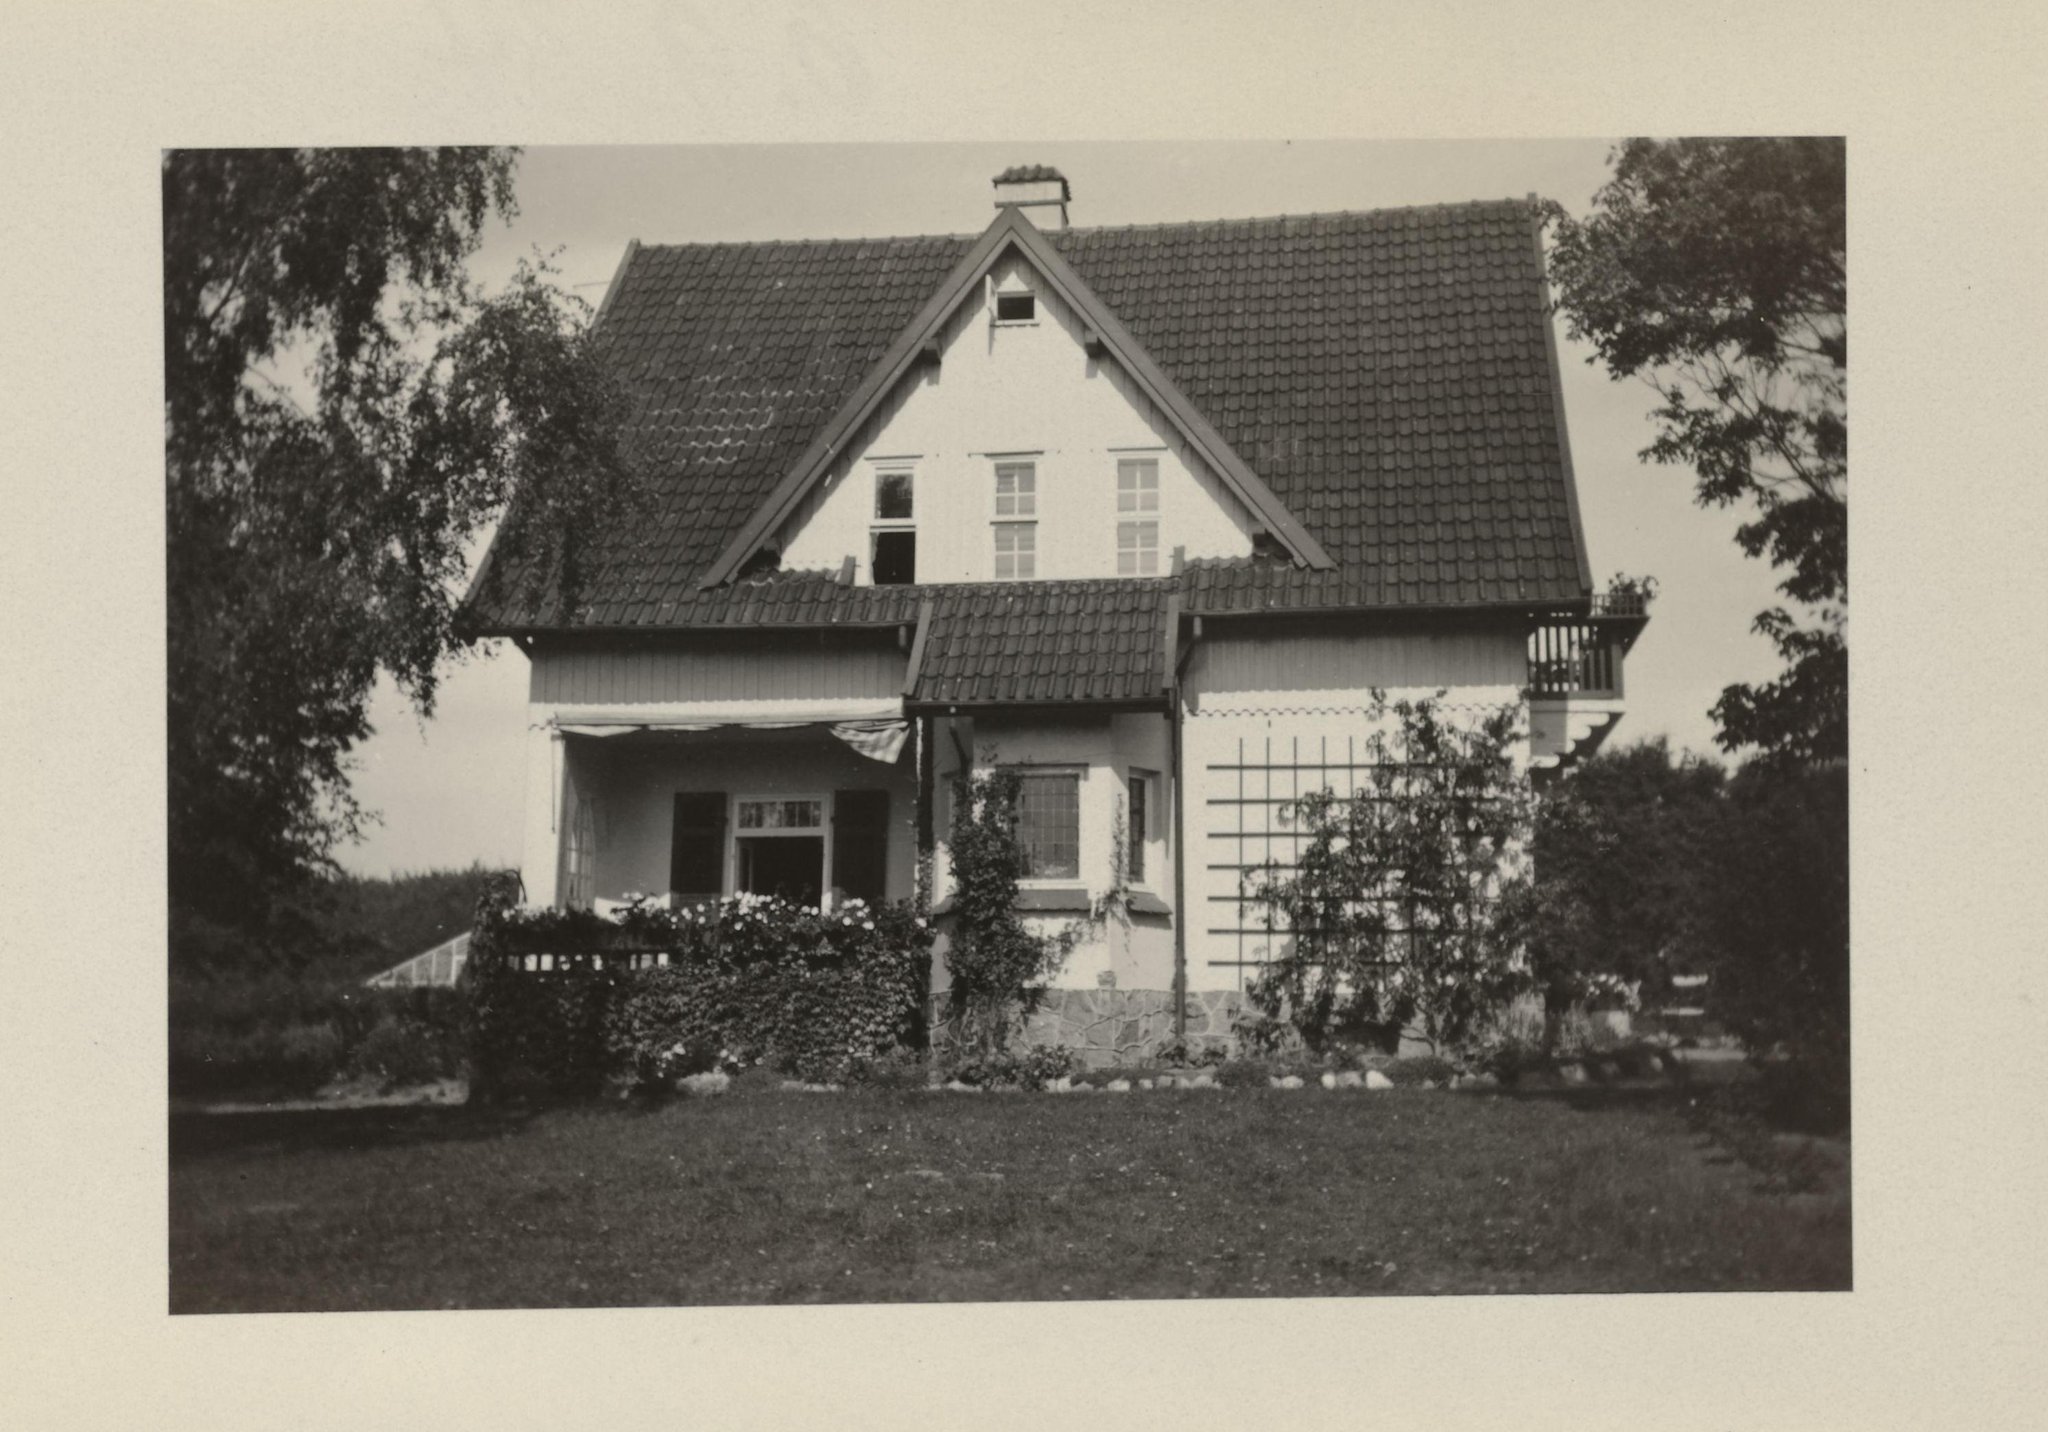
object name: photograph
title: Huis Fahrenkamp, met een witte driehoekige uitbouw voor op het dak en een rozenrek op de rechterkant van het huis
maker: Anonymous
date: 1934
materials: photographic support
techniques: gelatin silver print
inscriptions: date: ‘6.9.34. Haus Fahrenkamp 7’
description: Zicht op huis Fahrenkamp, met een witte driehoekige uitbouw voor op het dak en een rozenrek op de rechterkant van het huis.